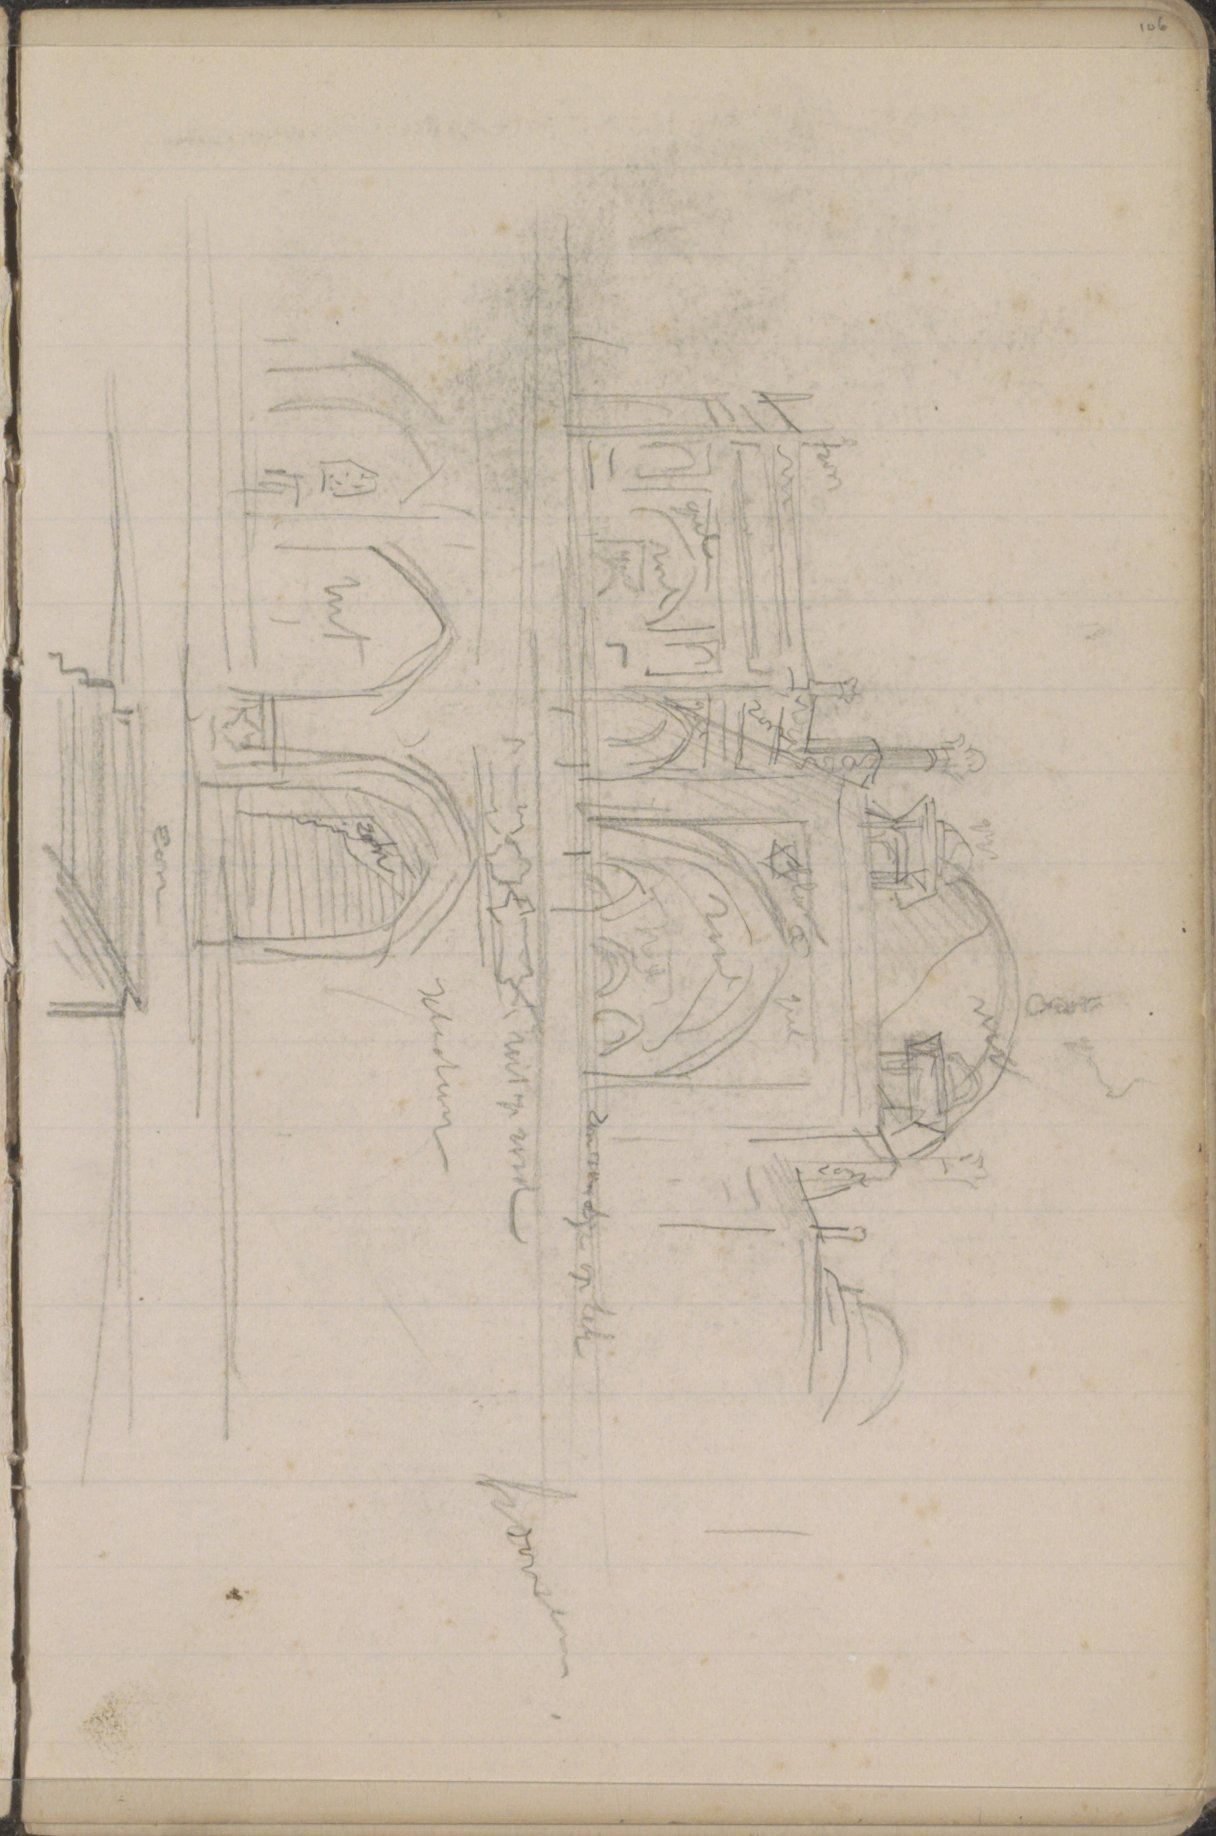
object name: sketchbook leaf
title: Gebouw met een koepeldak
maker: marius bauer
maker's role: draughtsman, print maker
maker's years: 1867-1932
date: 1897-1898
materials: pencil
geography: delhi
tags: flight of steps, architecture, dome ~ architecture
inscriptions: kleurnotitie, handgeschreven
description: Pagina 106 uit een schetsboek met 84 bladen.